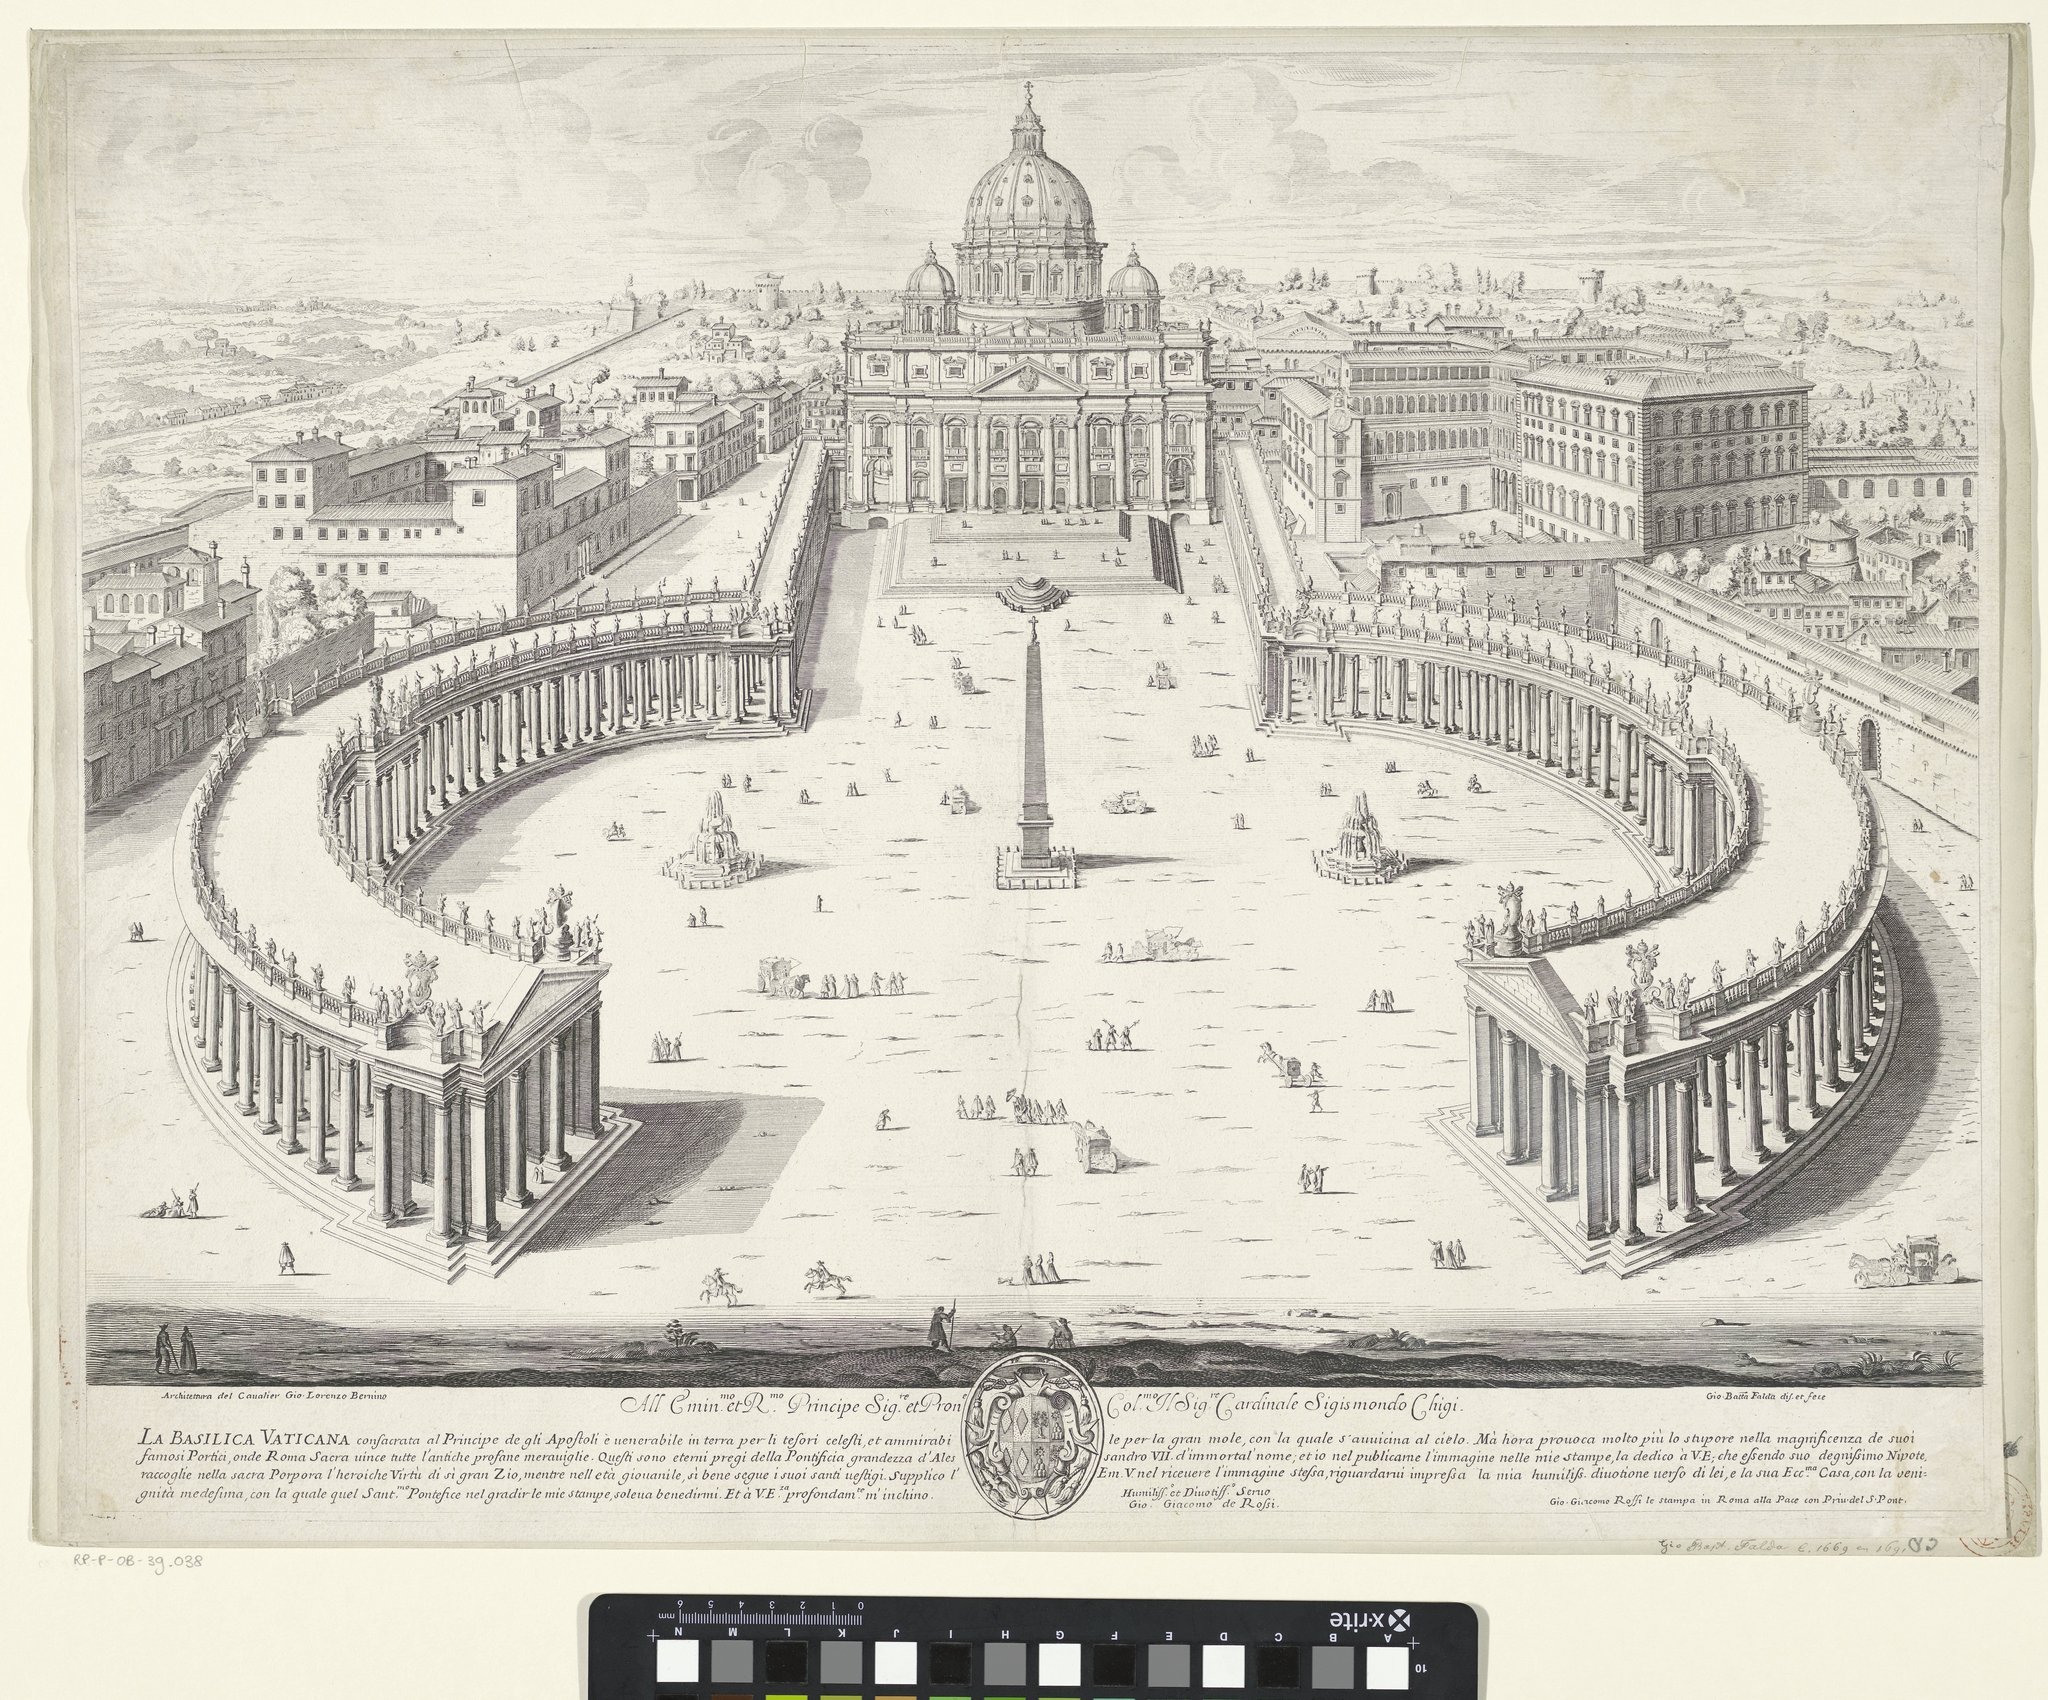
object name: print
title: Sint-Pietersbasiliek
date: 1578-1678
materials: paper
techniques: etching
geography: italy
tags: square, place, circus, etc., city-view in general; 'veduta', church (exterior)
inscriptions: collector's mark: Lugt 240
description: Gezicht op het Sint-Pietersplein en de Sint-Pietersbasiliek in Vaticaanstad.